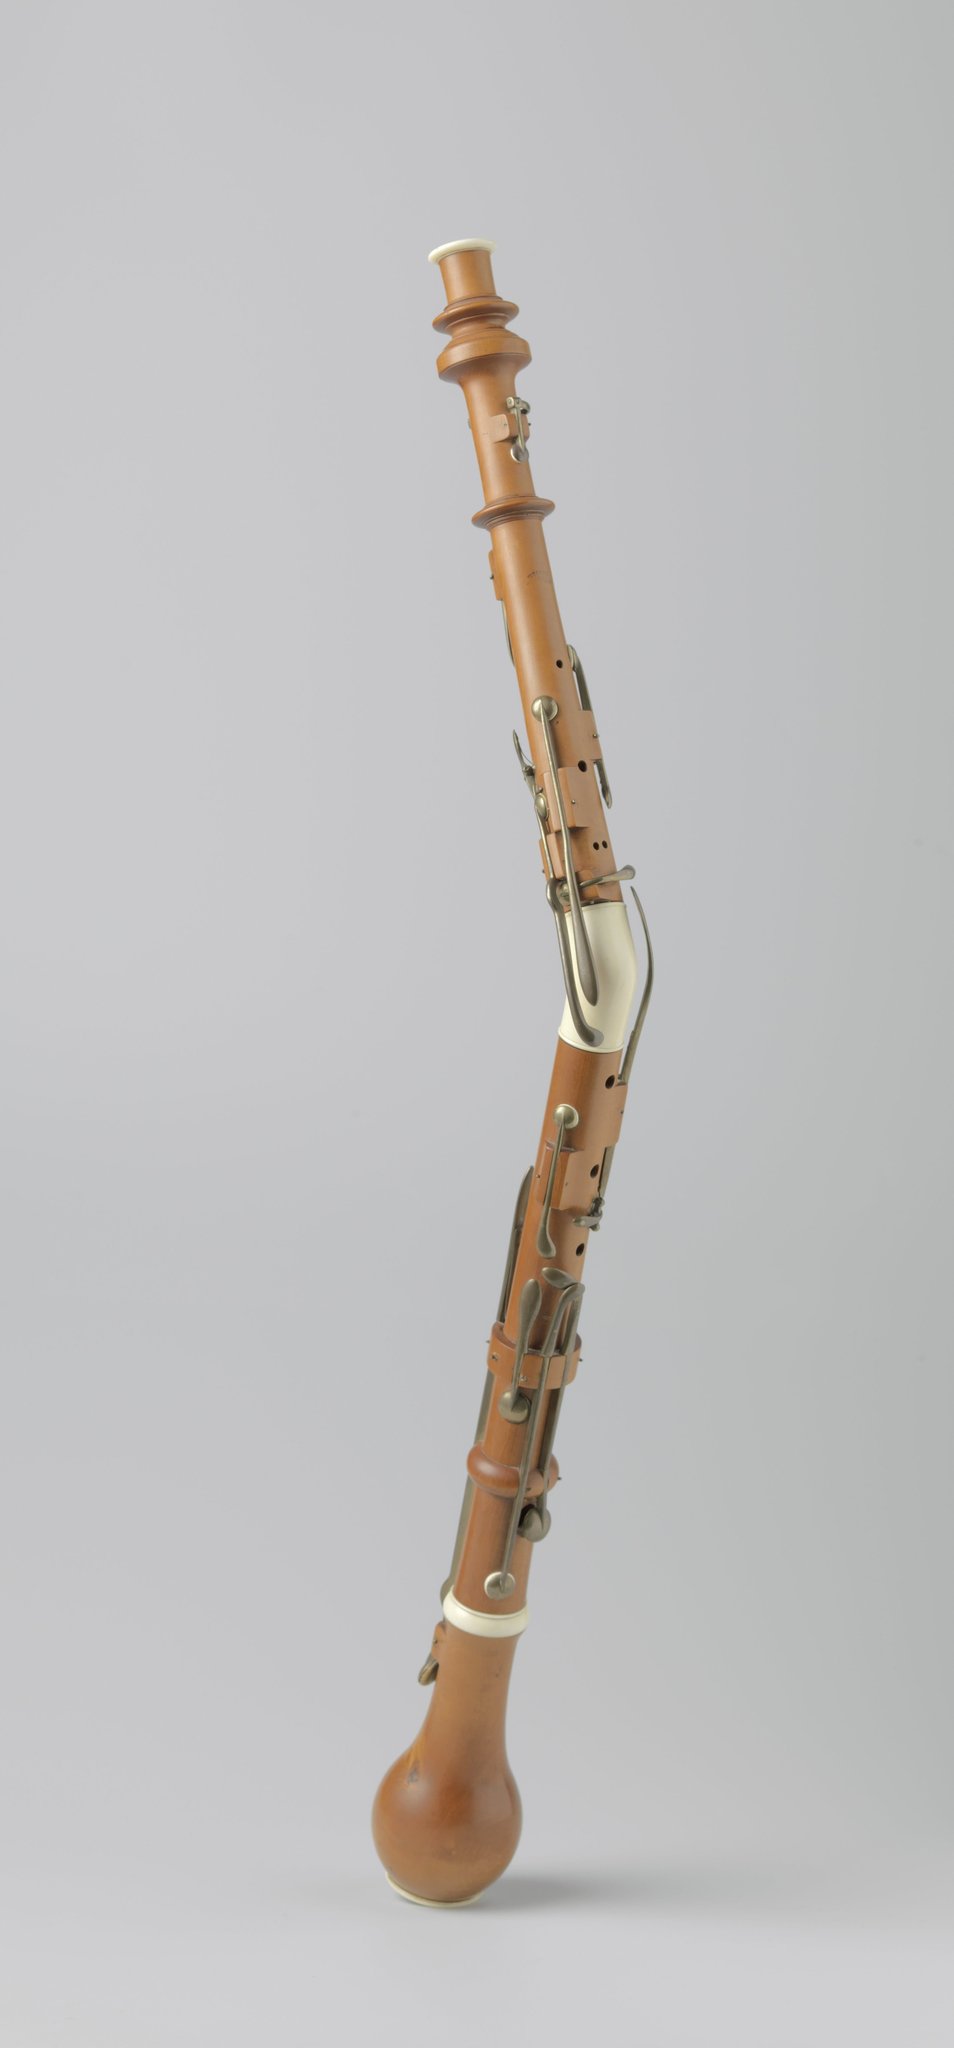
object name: oboe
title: English horn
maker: johann adam heckel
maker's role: musical instrument maker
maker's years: 1812-1877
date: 1830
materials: copper, ivory, wood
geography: biebrich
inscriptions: mark, on the upper part, stamped: ‘HECKEL/ BIEBRICH’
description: Engelse hoorn (of Althobo), gemerkt: HECKEL/ BIEBRICH